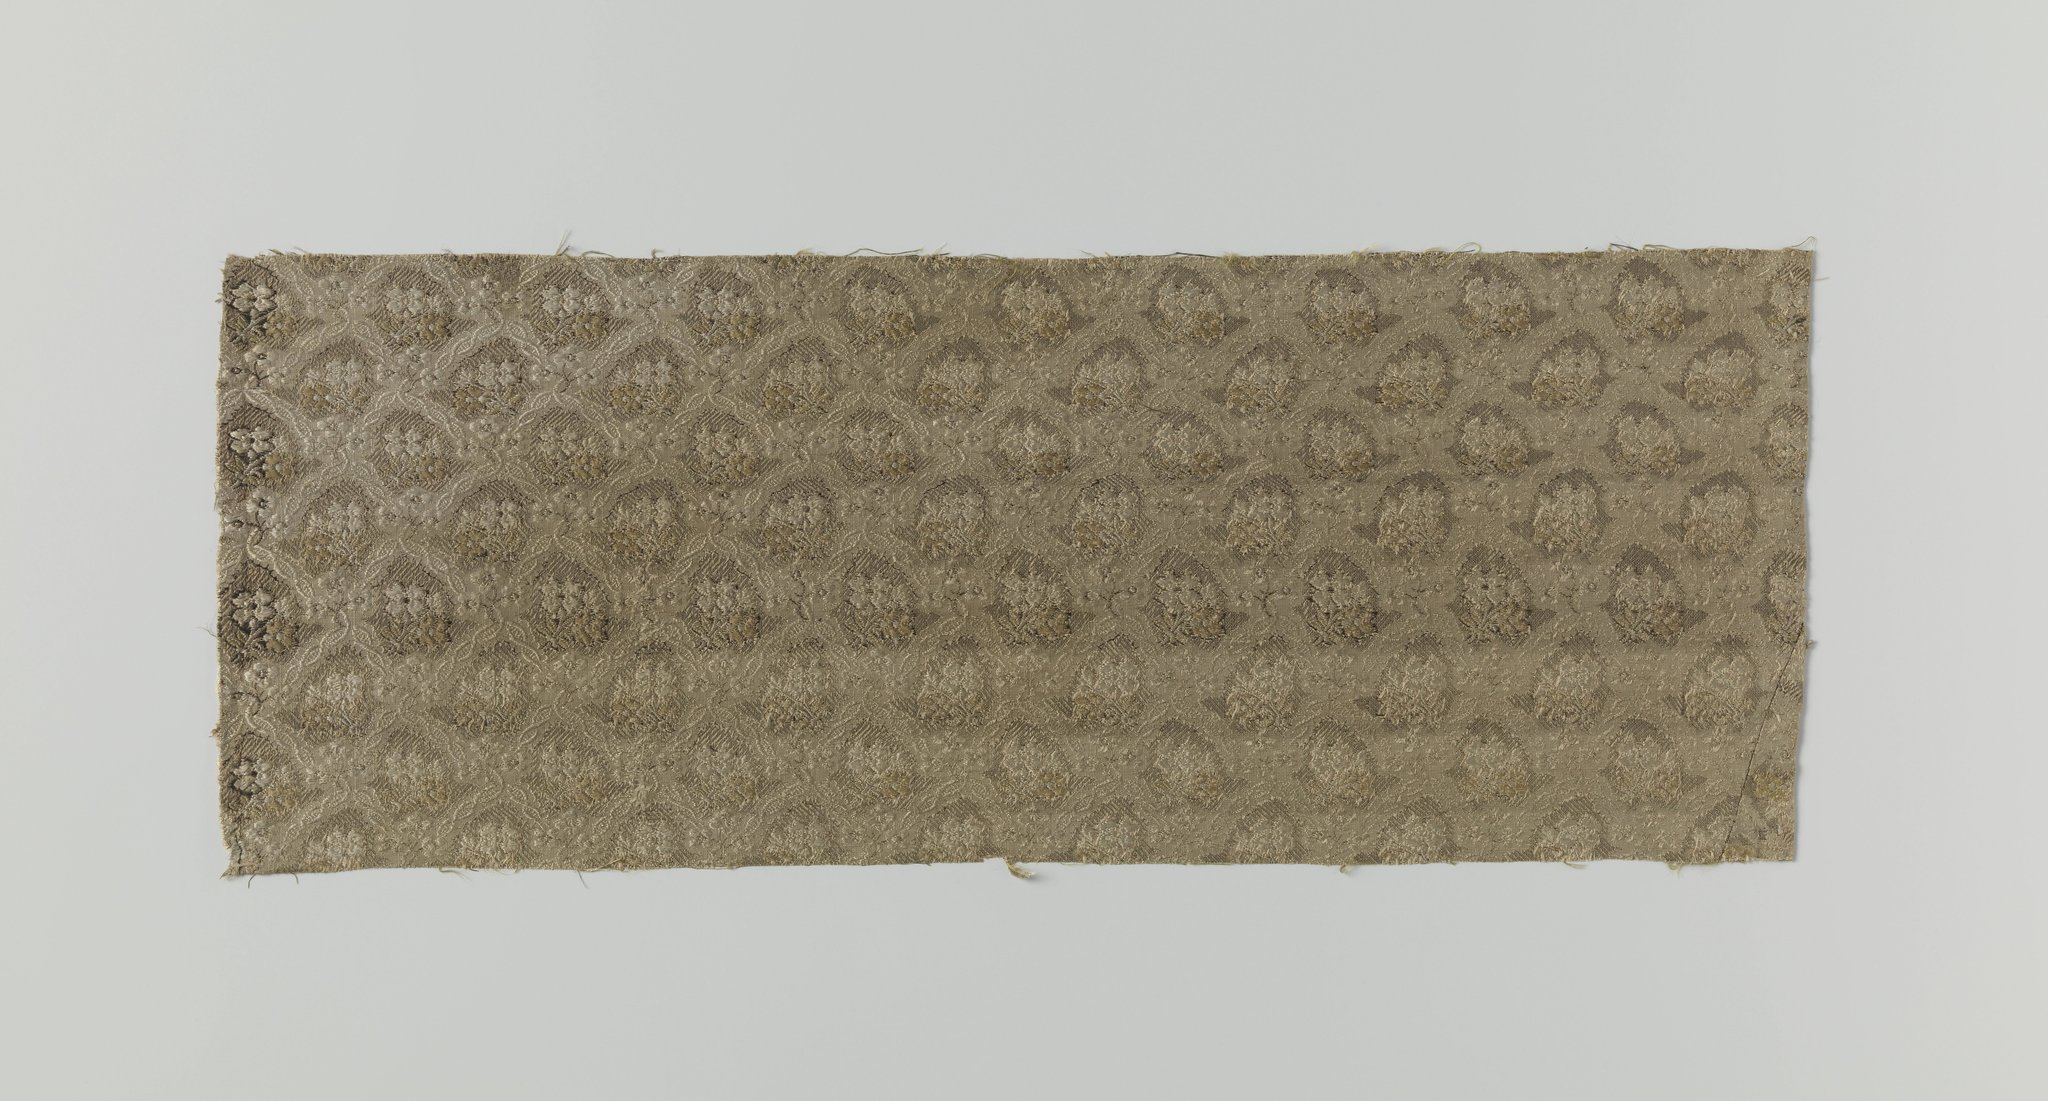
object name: fragment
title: Fragment veelkleurig droguet liseré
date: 1750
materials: silk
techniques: droguet liseré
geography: germany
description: Fragment veelkleurig zijdeweefsel. Het fragment heeft een lichtgroen netwerk met witte intertwined slingers met een bloemtak op de snijpunten. De slingers vormen velden waarin een bloemtak in wit, bruin en groen.